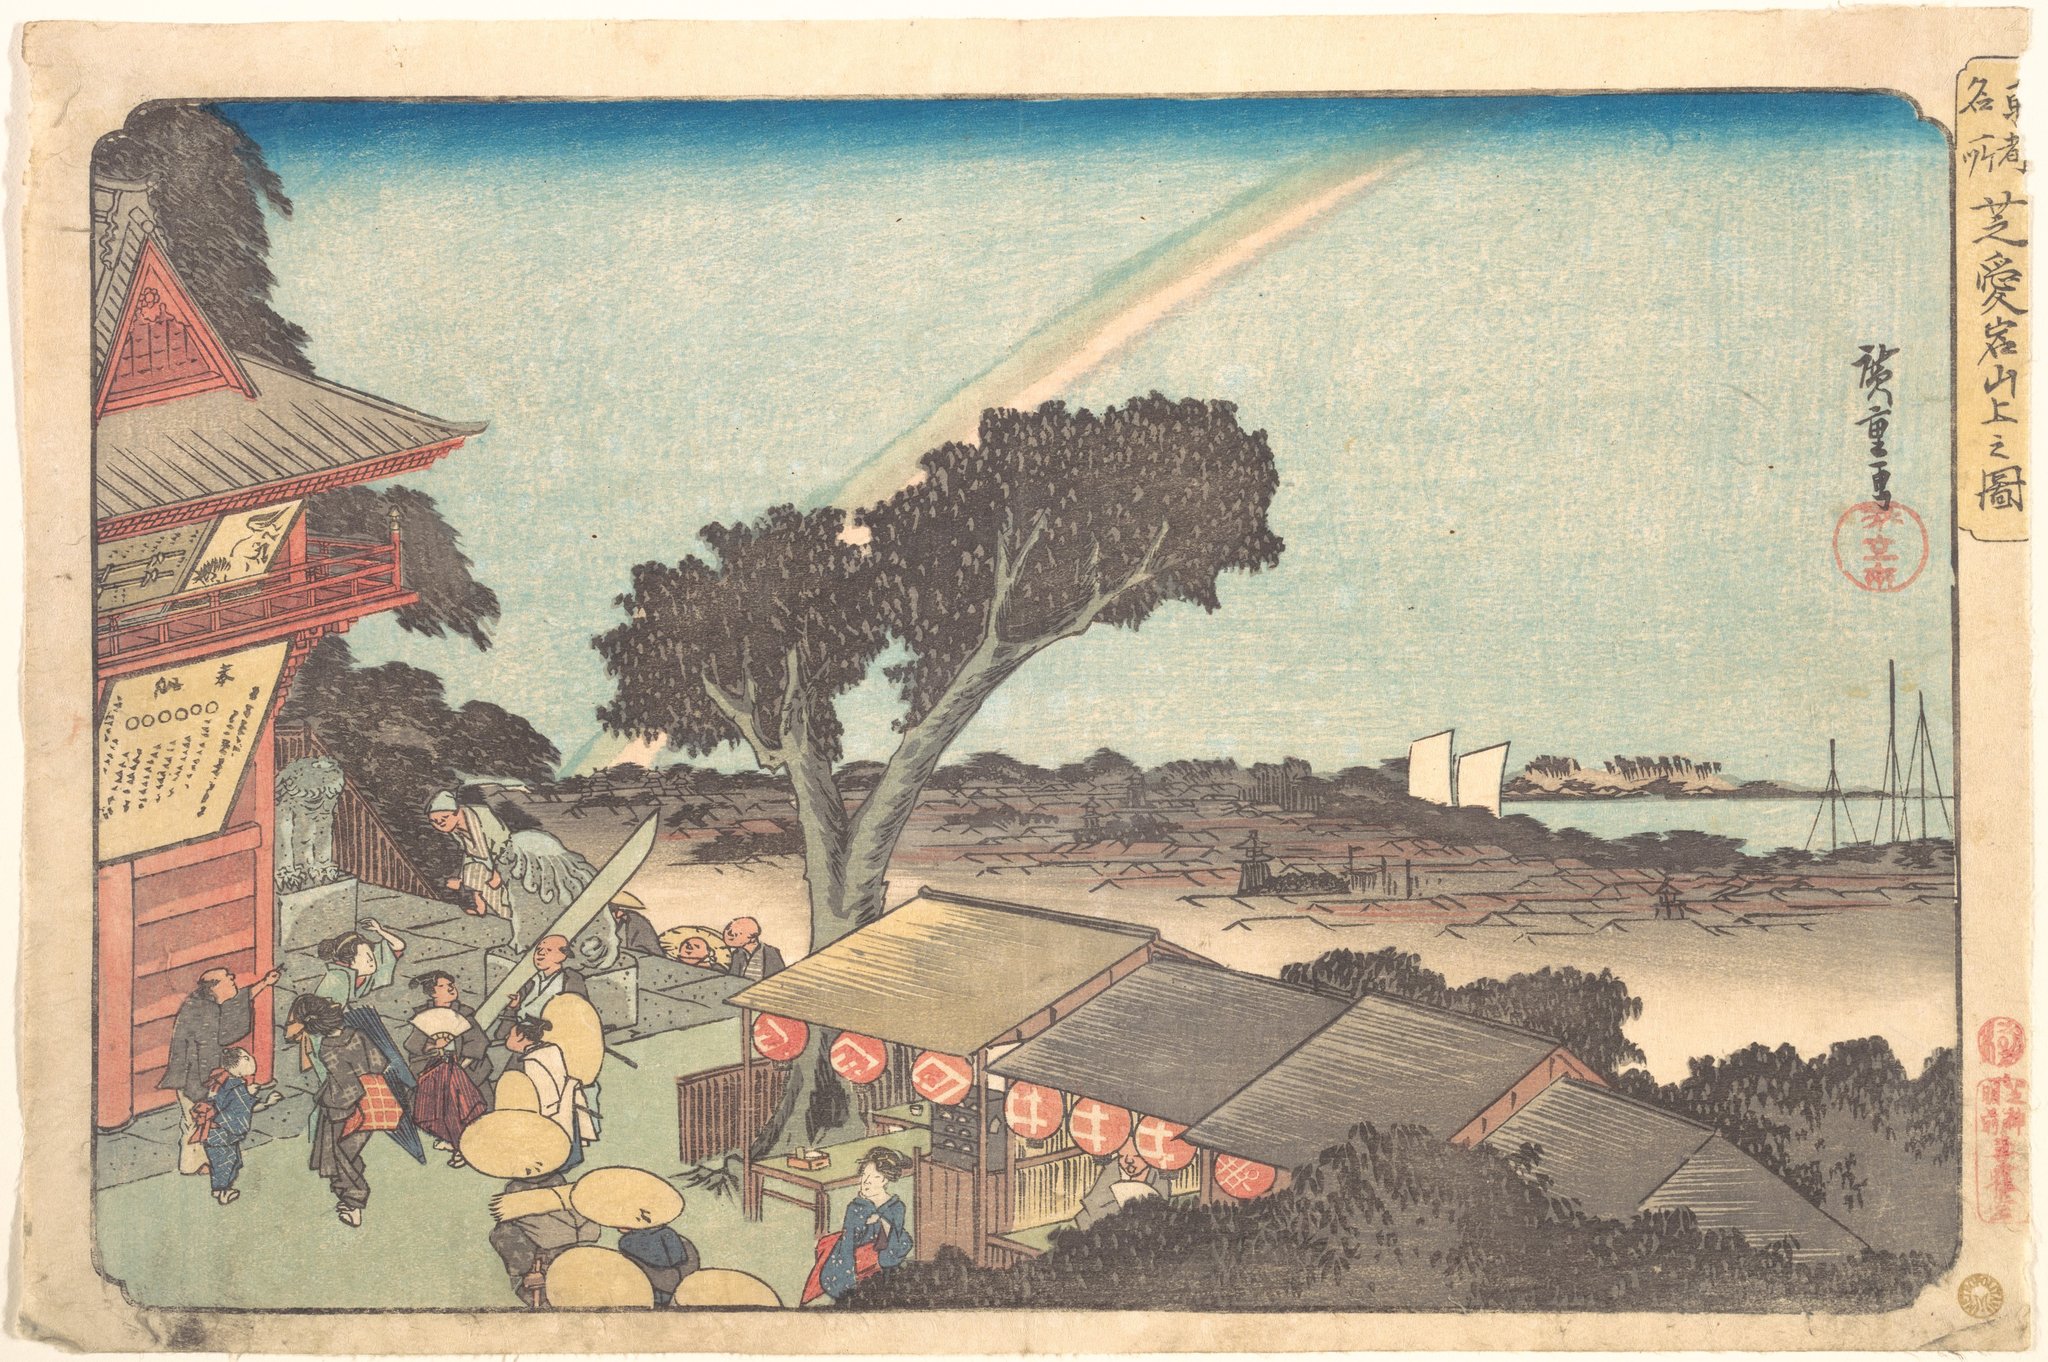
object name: print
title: Shiba Atago Sanjo no Zu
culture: japanese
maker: utagawa hiroshige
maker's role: artist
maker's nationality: japanese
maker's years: 1797-1858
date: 1833-1834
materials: ink, paper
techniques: woodblock print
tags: human figures,houses,landscapes,trees,rainbows